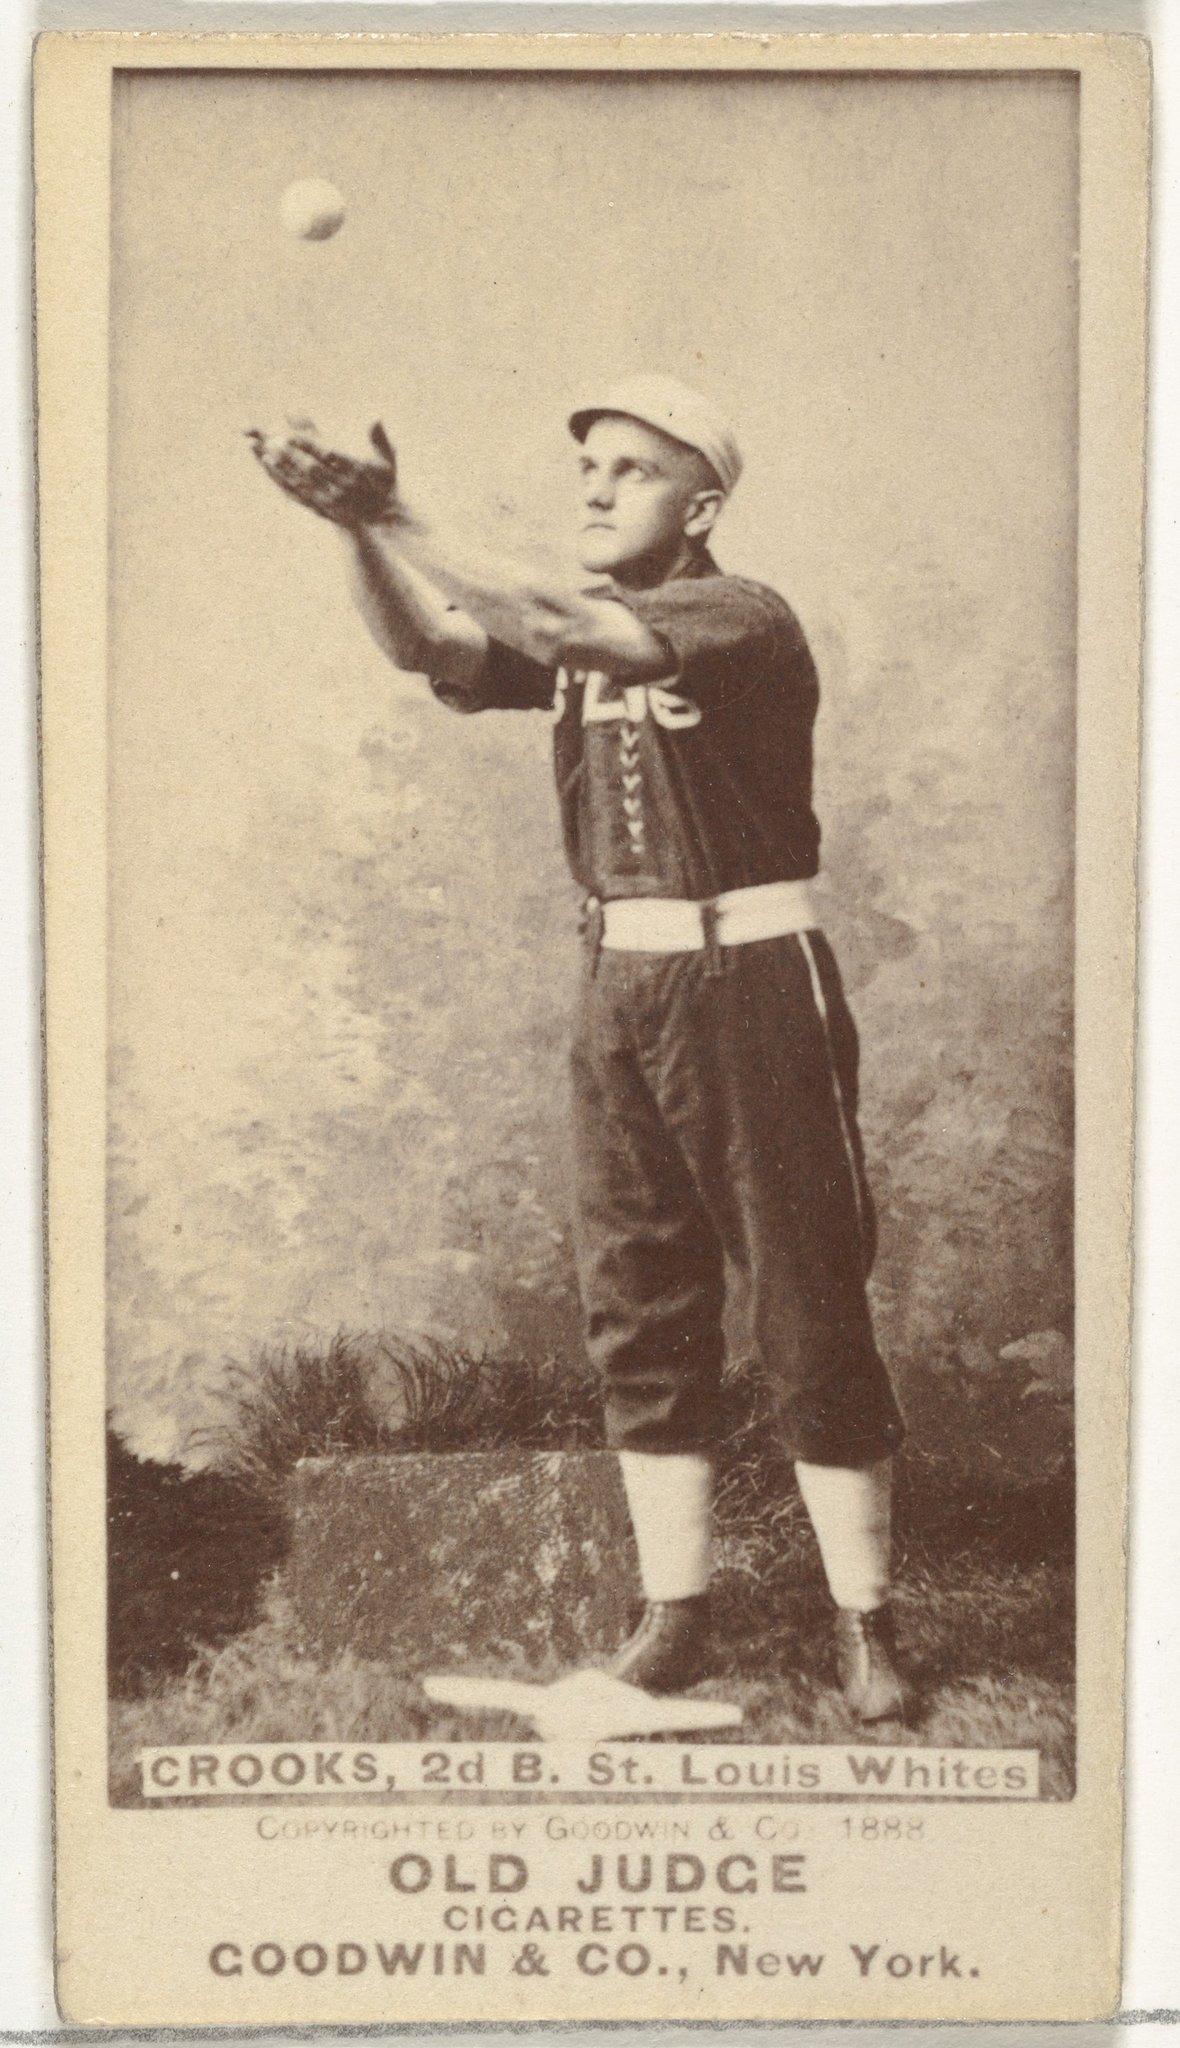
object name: baseball card, photograph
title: Crooks, 2nd Base, St. Louis Whites, from the Old Judge series (N172) for Old Judge Cigarettes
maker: goodwin & company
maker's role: publisher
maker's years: 1850-1950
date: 1888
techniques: albumen silver print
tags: men,portraits,baseball,athletes